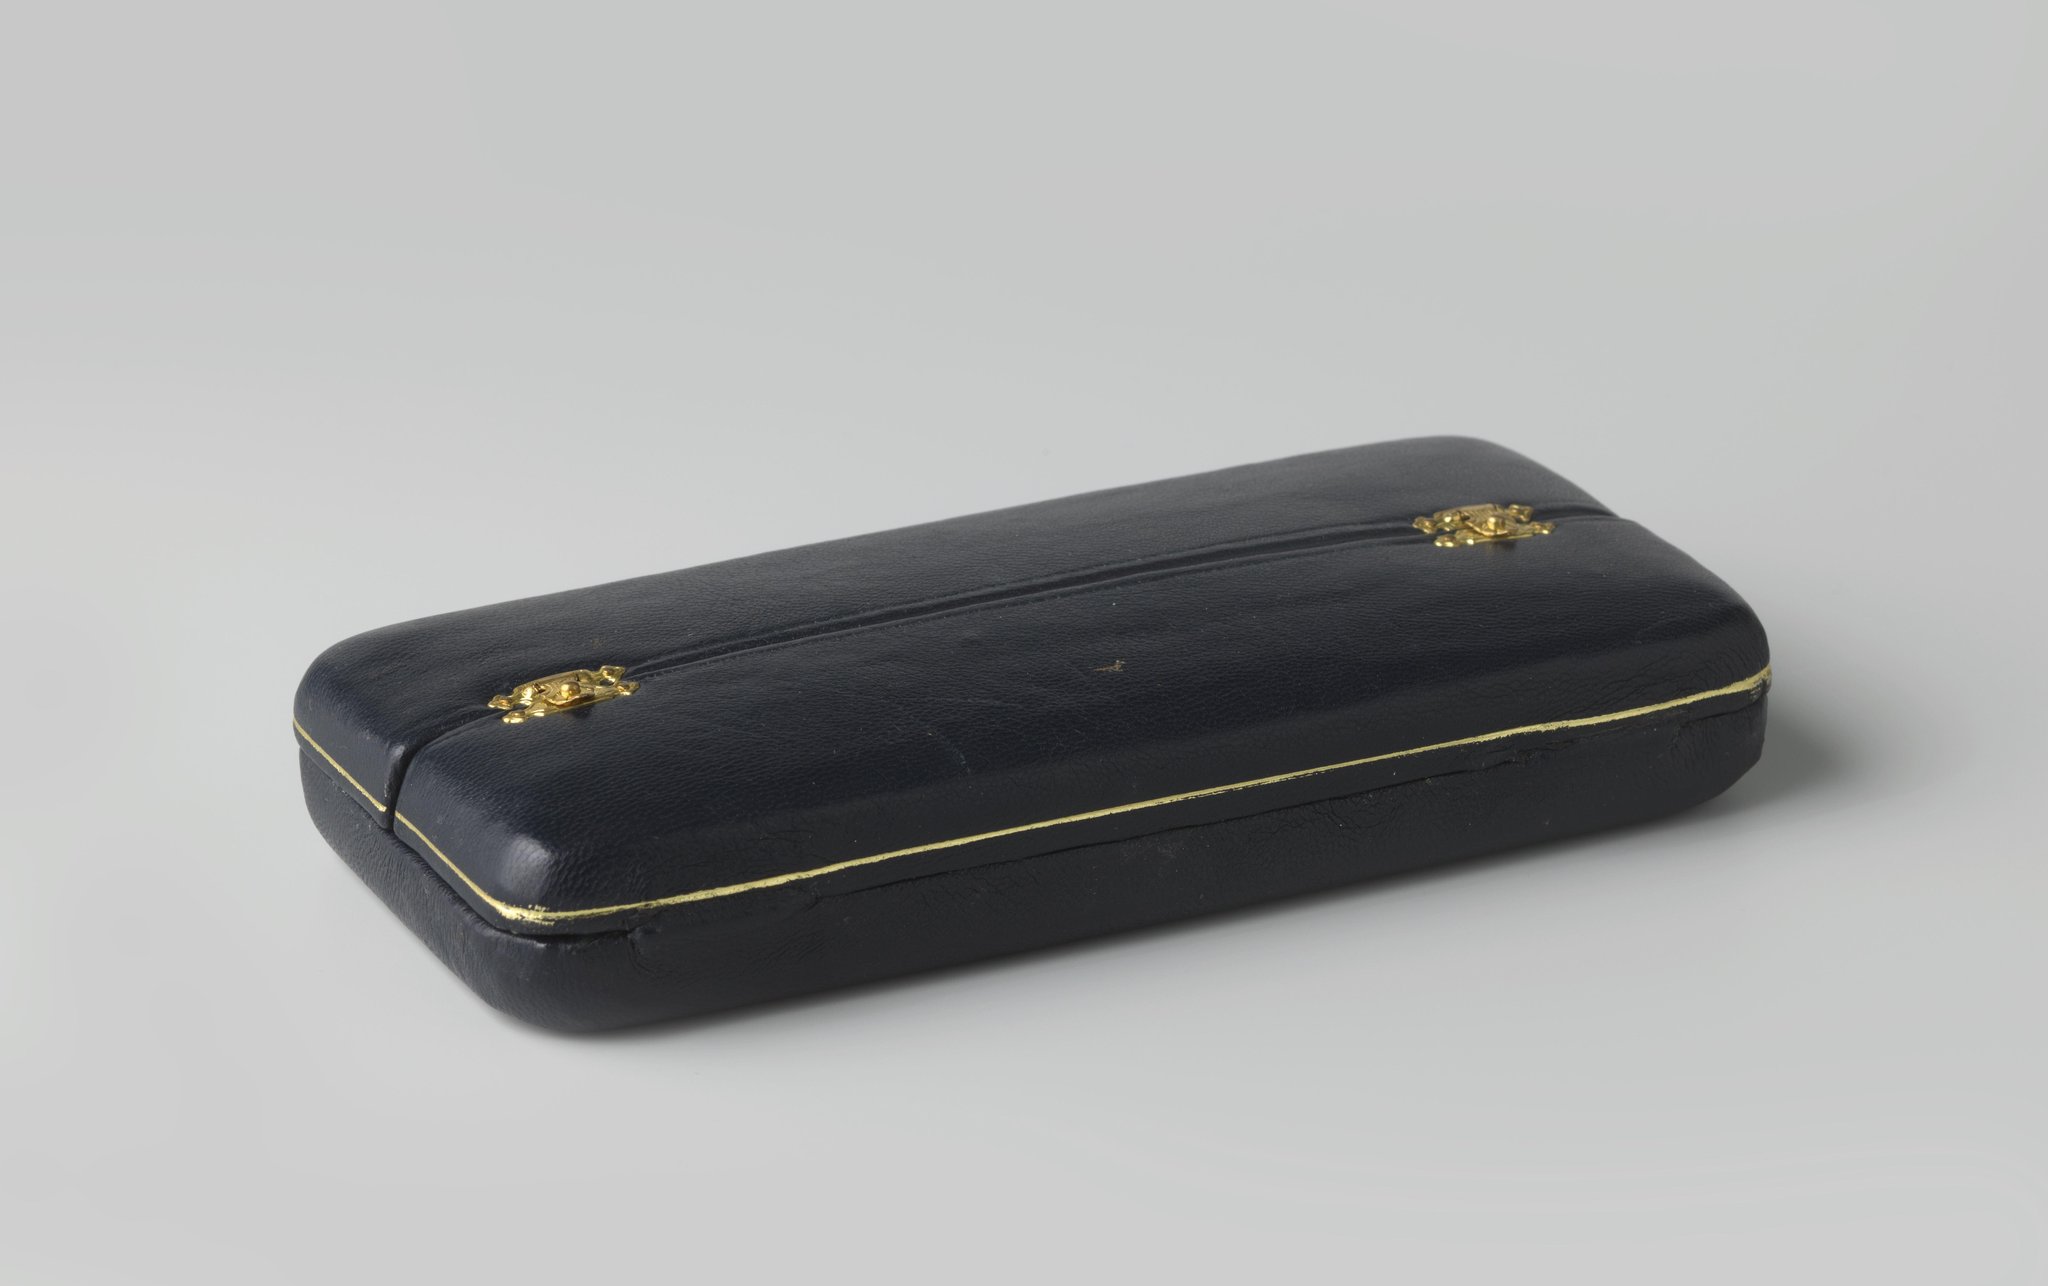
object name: flacon, flakon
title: Etui behorende bij flacon BK-2009-50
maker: alexis falize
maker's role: goldsmith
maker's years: 1811-1898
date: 1867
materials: leather, velvet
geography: paris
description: Etui behorende bij flacon met een geëmailleerde voorstelling van een kraanvogel in een bloeiende boom (BK-2009-50)